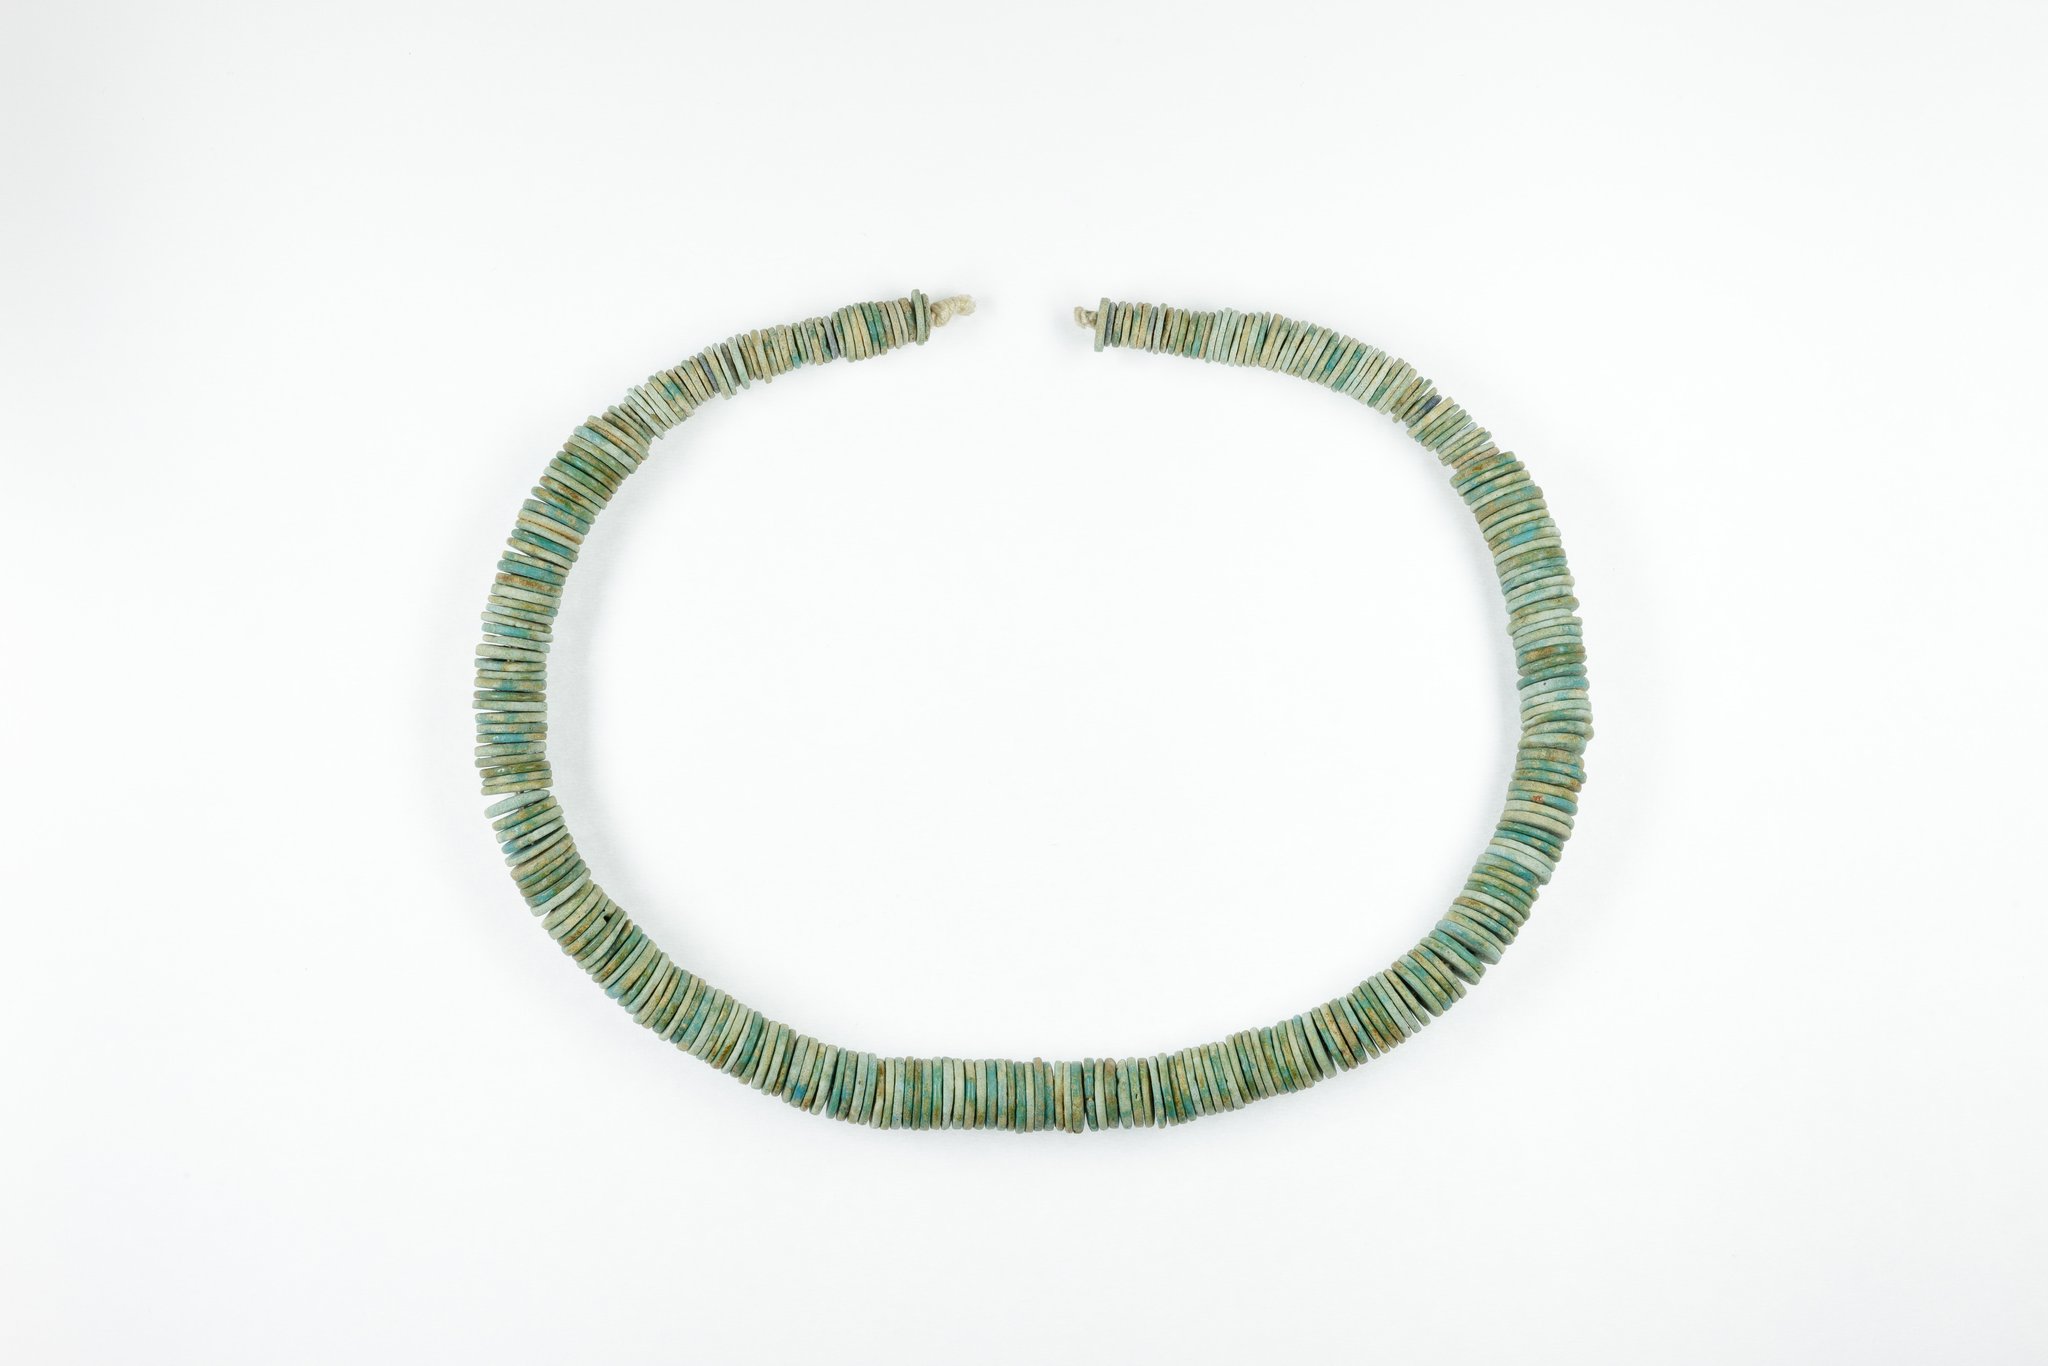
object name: bead, disk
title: String of Disk Beads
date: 1425-1295 BCE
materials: faience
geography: northern upper egypt